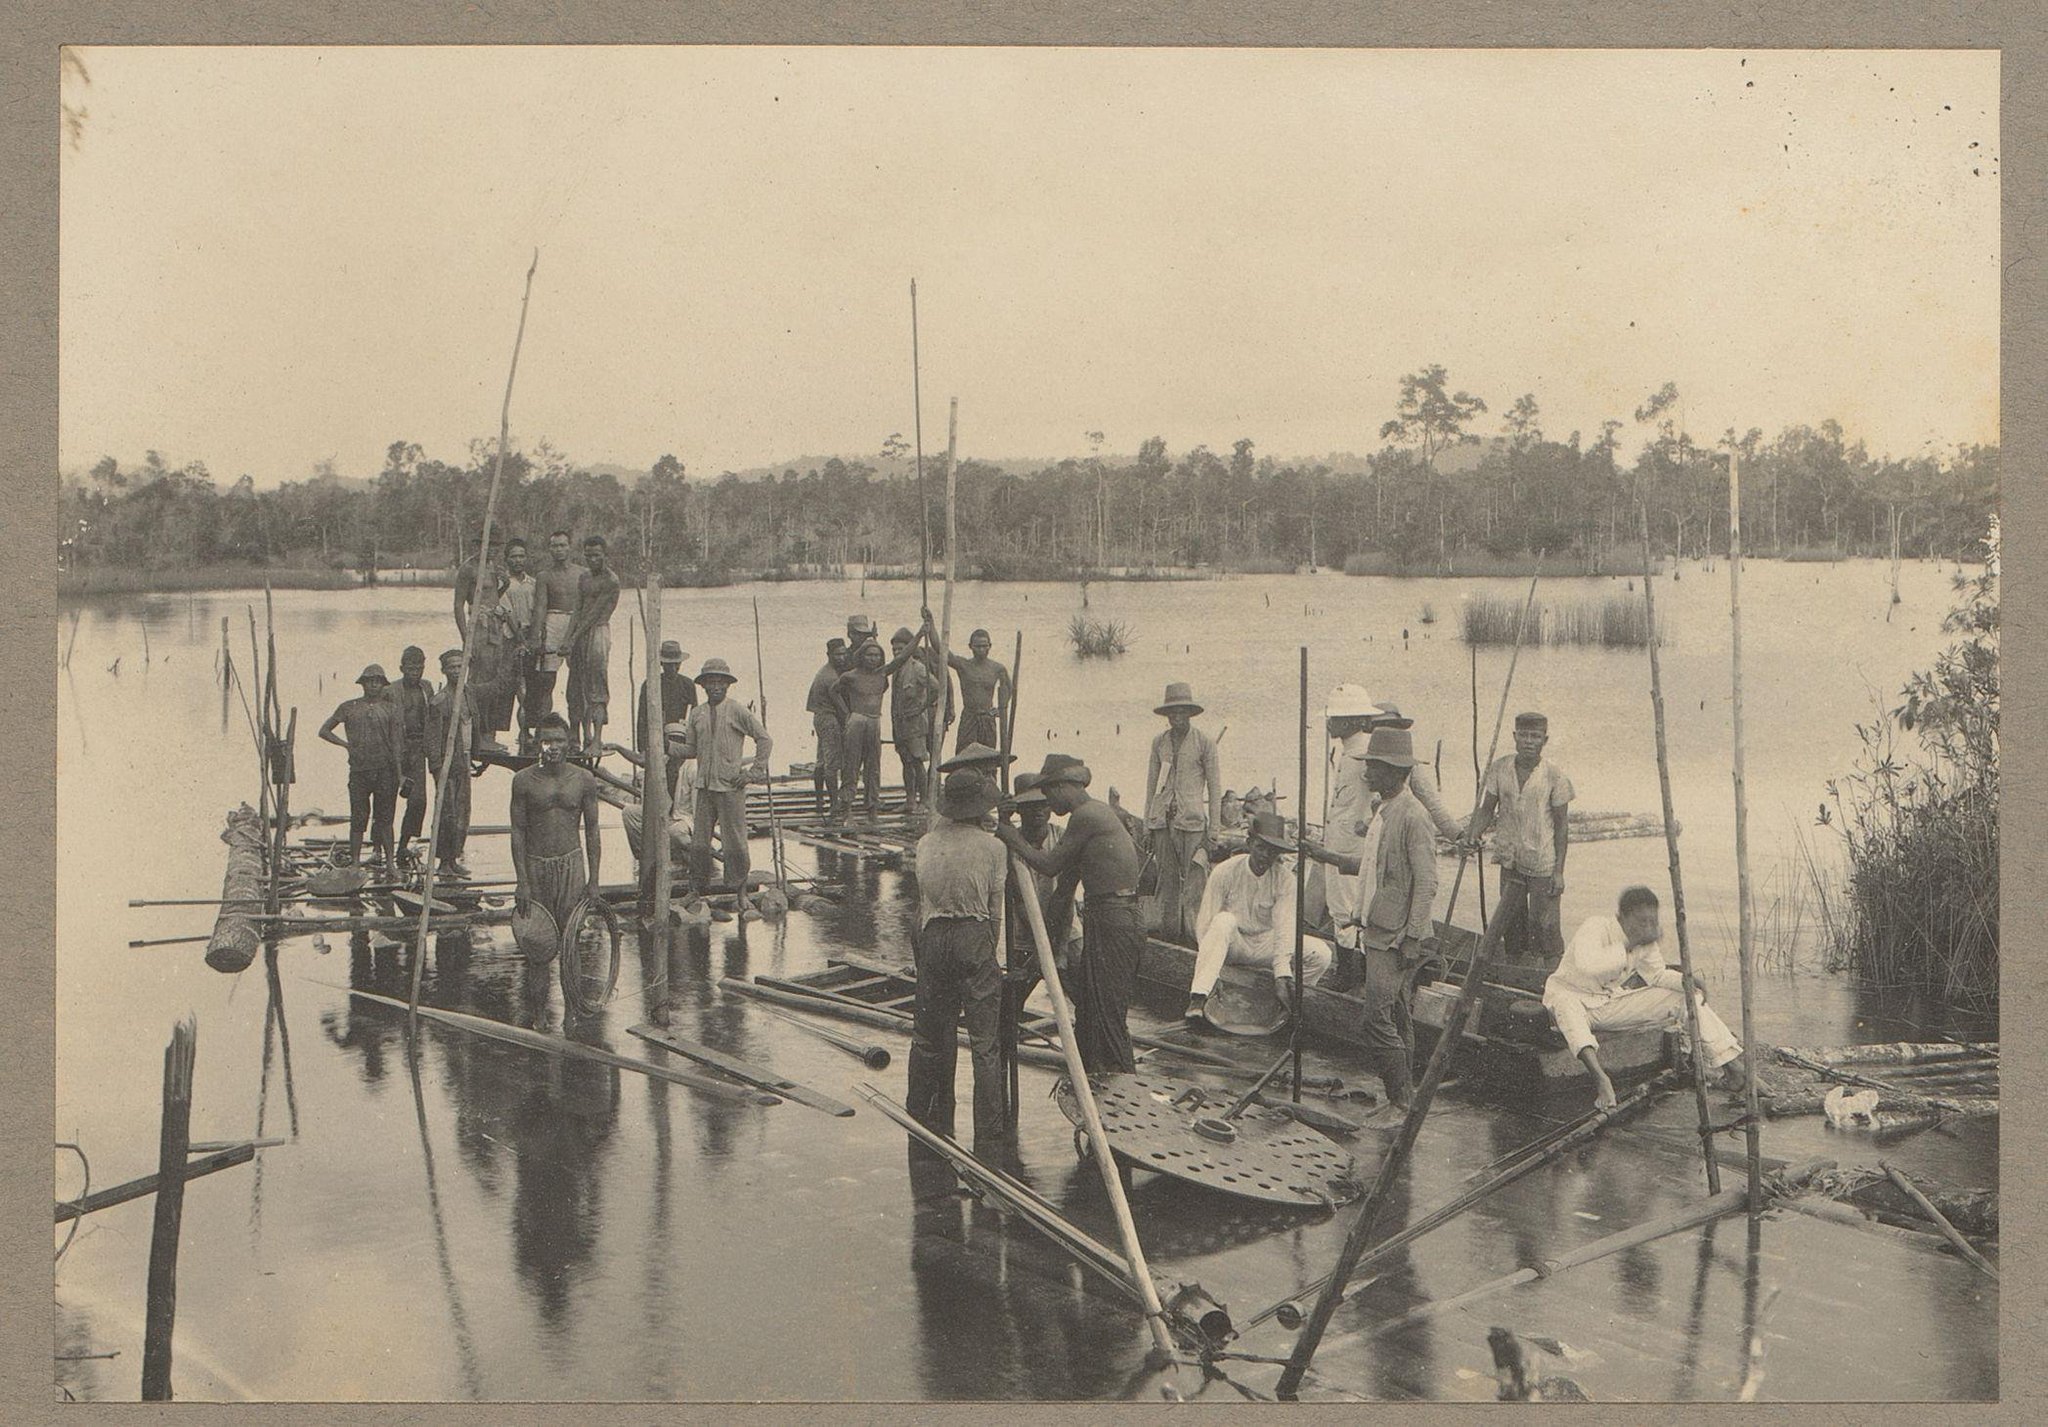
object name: photograph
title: Onderzoek naar Tinerts in het tebat der mijn No. 2 Blinjoe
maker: Anonymous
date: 1914-1919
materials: photographic support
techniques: gelatin silver print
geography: bangka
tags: robert julius boers, colonial system, mining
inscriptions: inscription: ‘Onderzoek naar Tinerts in het tebat der mijn No. 2 Blinjoe’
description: Onderzoek naar tinerts door een grote groep mannen op een stellage in het water bij een tinmijn te Blinjoe. Onderdeel van het fotoalbum aangeboden aan Robert Julius Boers bij zijn vertrek naar Nederland in 1919 door het personeel van de Banka-tinwinning.